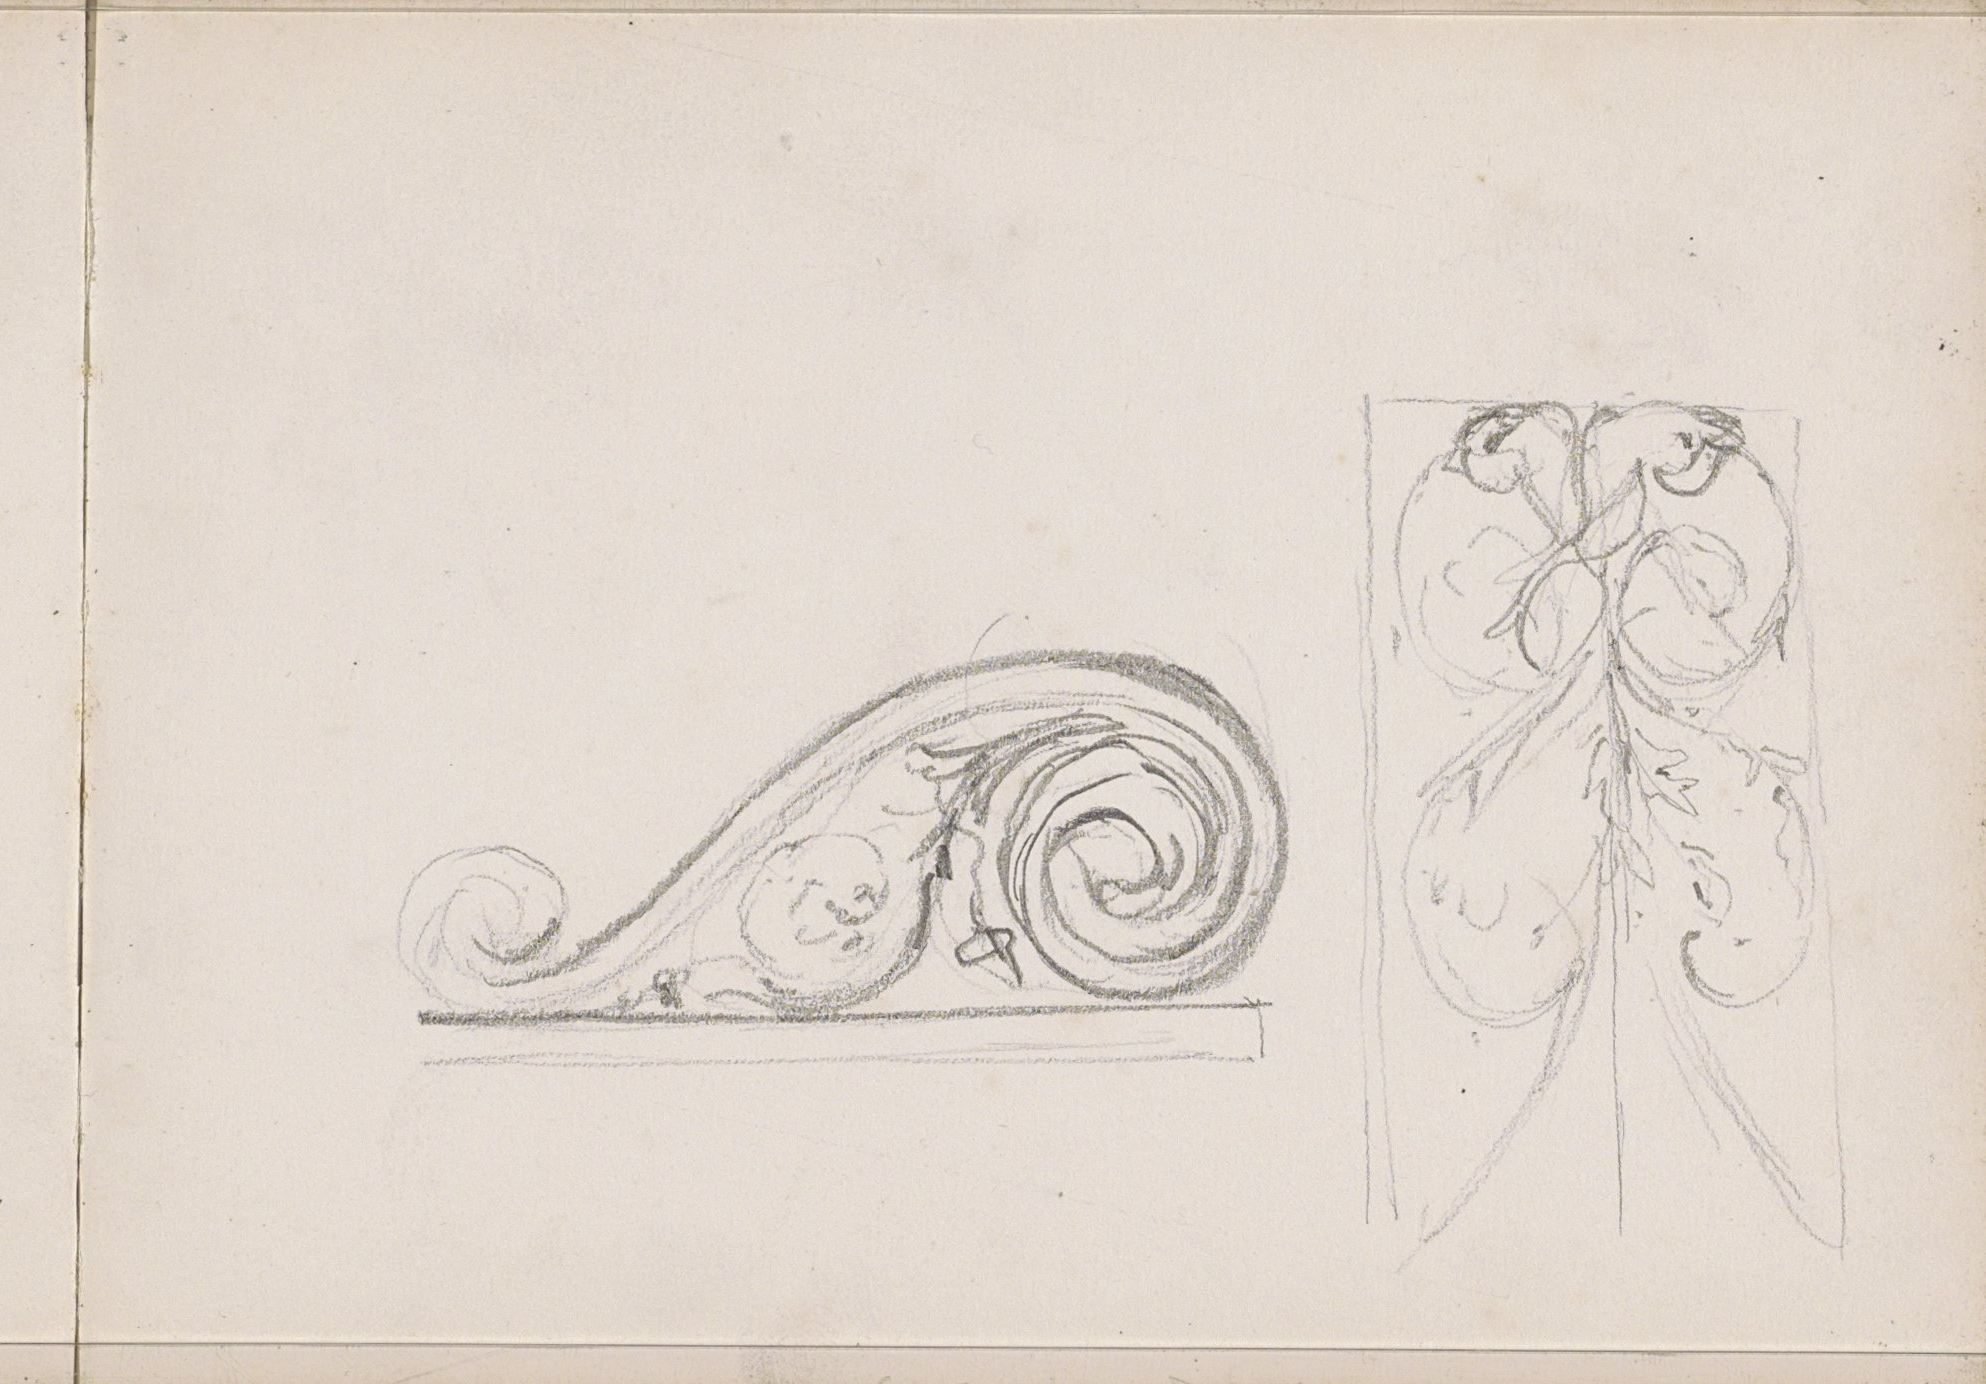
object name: sketchbook leaf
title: Voluut en een floraal ornament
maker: jac van looij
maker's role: draughtsman, painter, print maker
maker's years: 1855-1930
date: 1877-1880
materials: paper, pencil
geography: amsterdam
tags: ribbon, scroll, banderole ~ ornament, flowers ~ ornament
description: Blad 20 recto uit een schetsboek met 27 bladen.